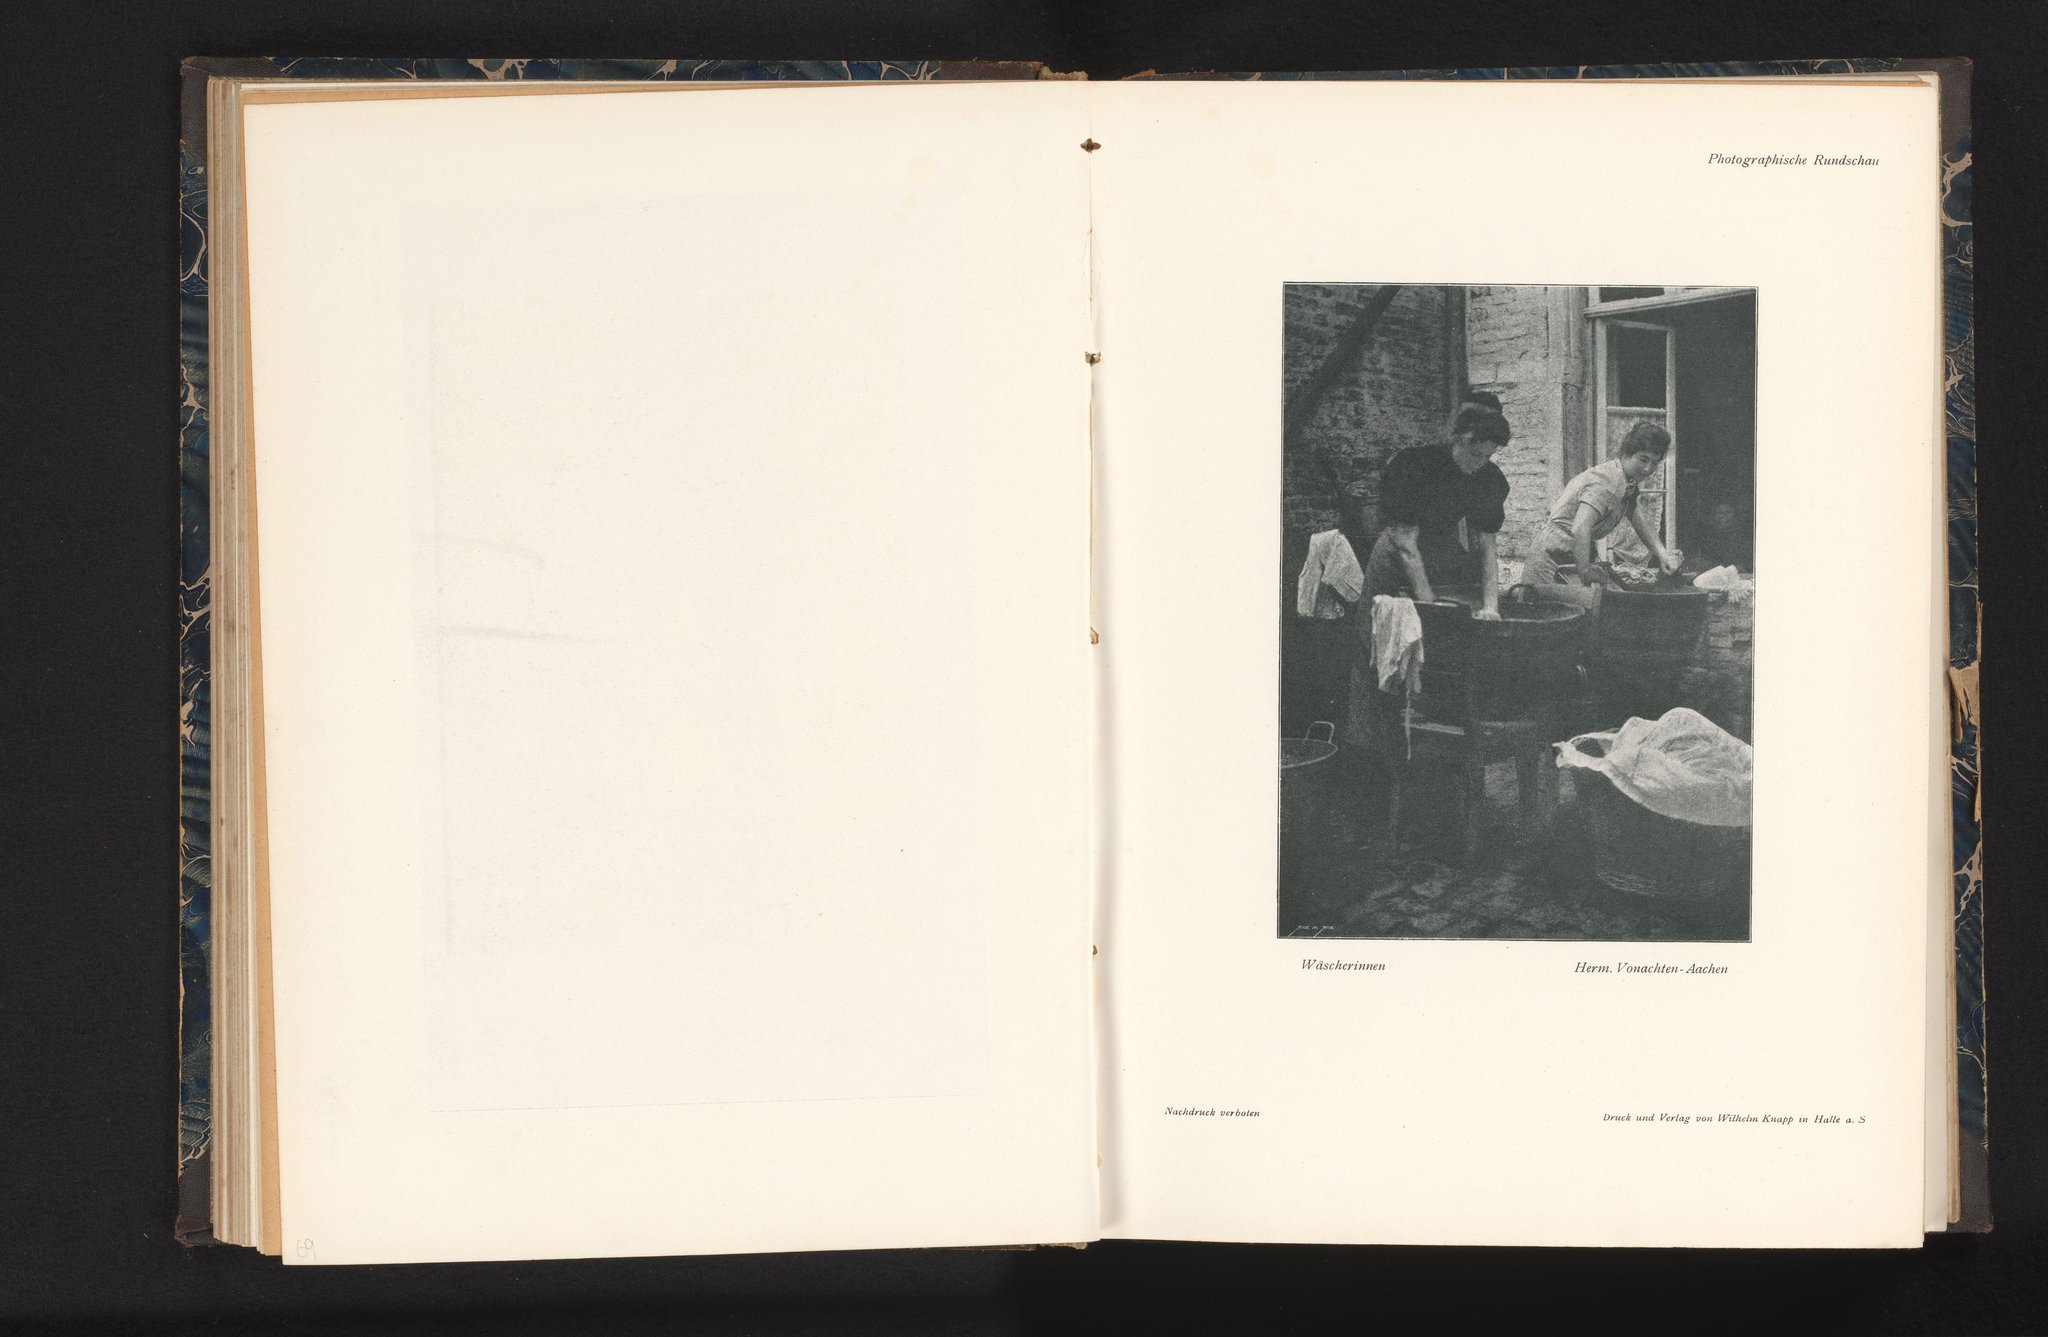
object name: page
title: Wäscherinnen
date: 1897-1902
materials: paper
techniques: autotype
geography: halle an der saale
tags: adult woman, laundering